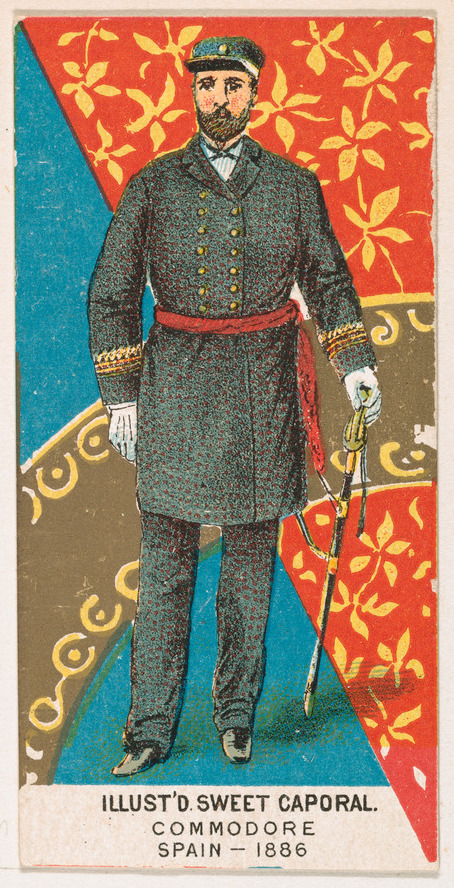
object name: print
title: Commodore, Spain, 1886, from the Military Series (N224) issued by Kinney Tobacco Company to promote Sweet Caporal Cigarettes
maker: kinney brothers tobacco company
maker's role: publisher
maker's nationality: american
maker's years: 1869-2011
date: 1888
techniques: color lithograph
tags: military,swords,men